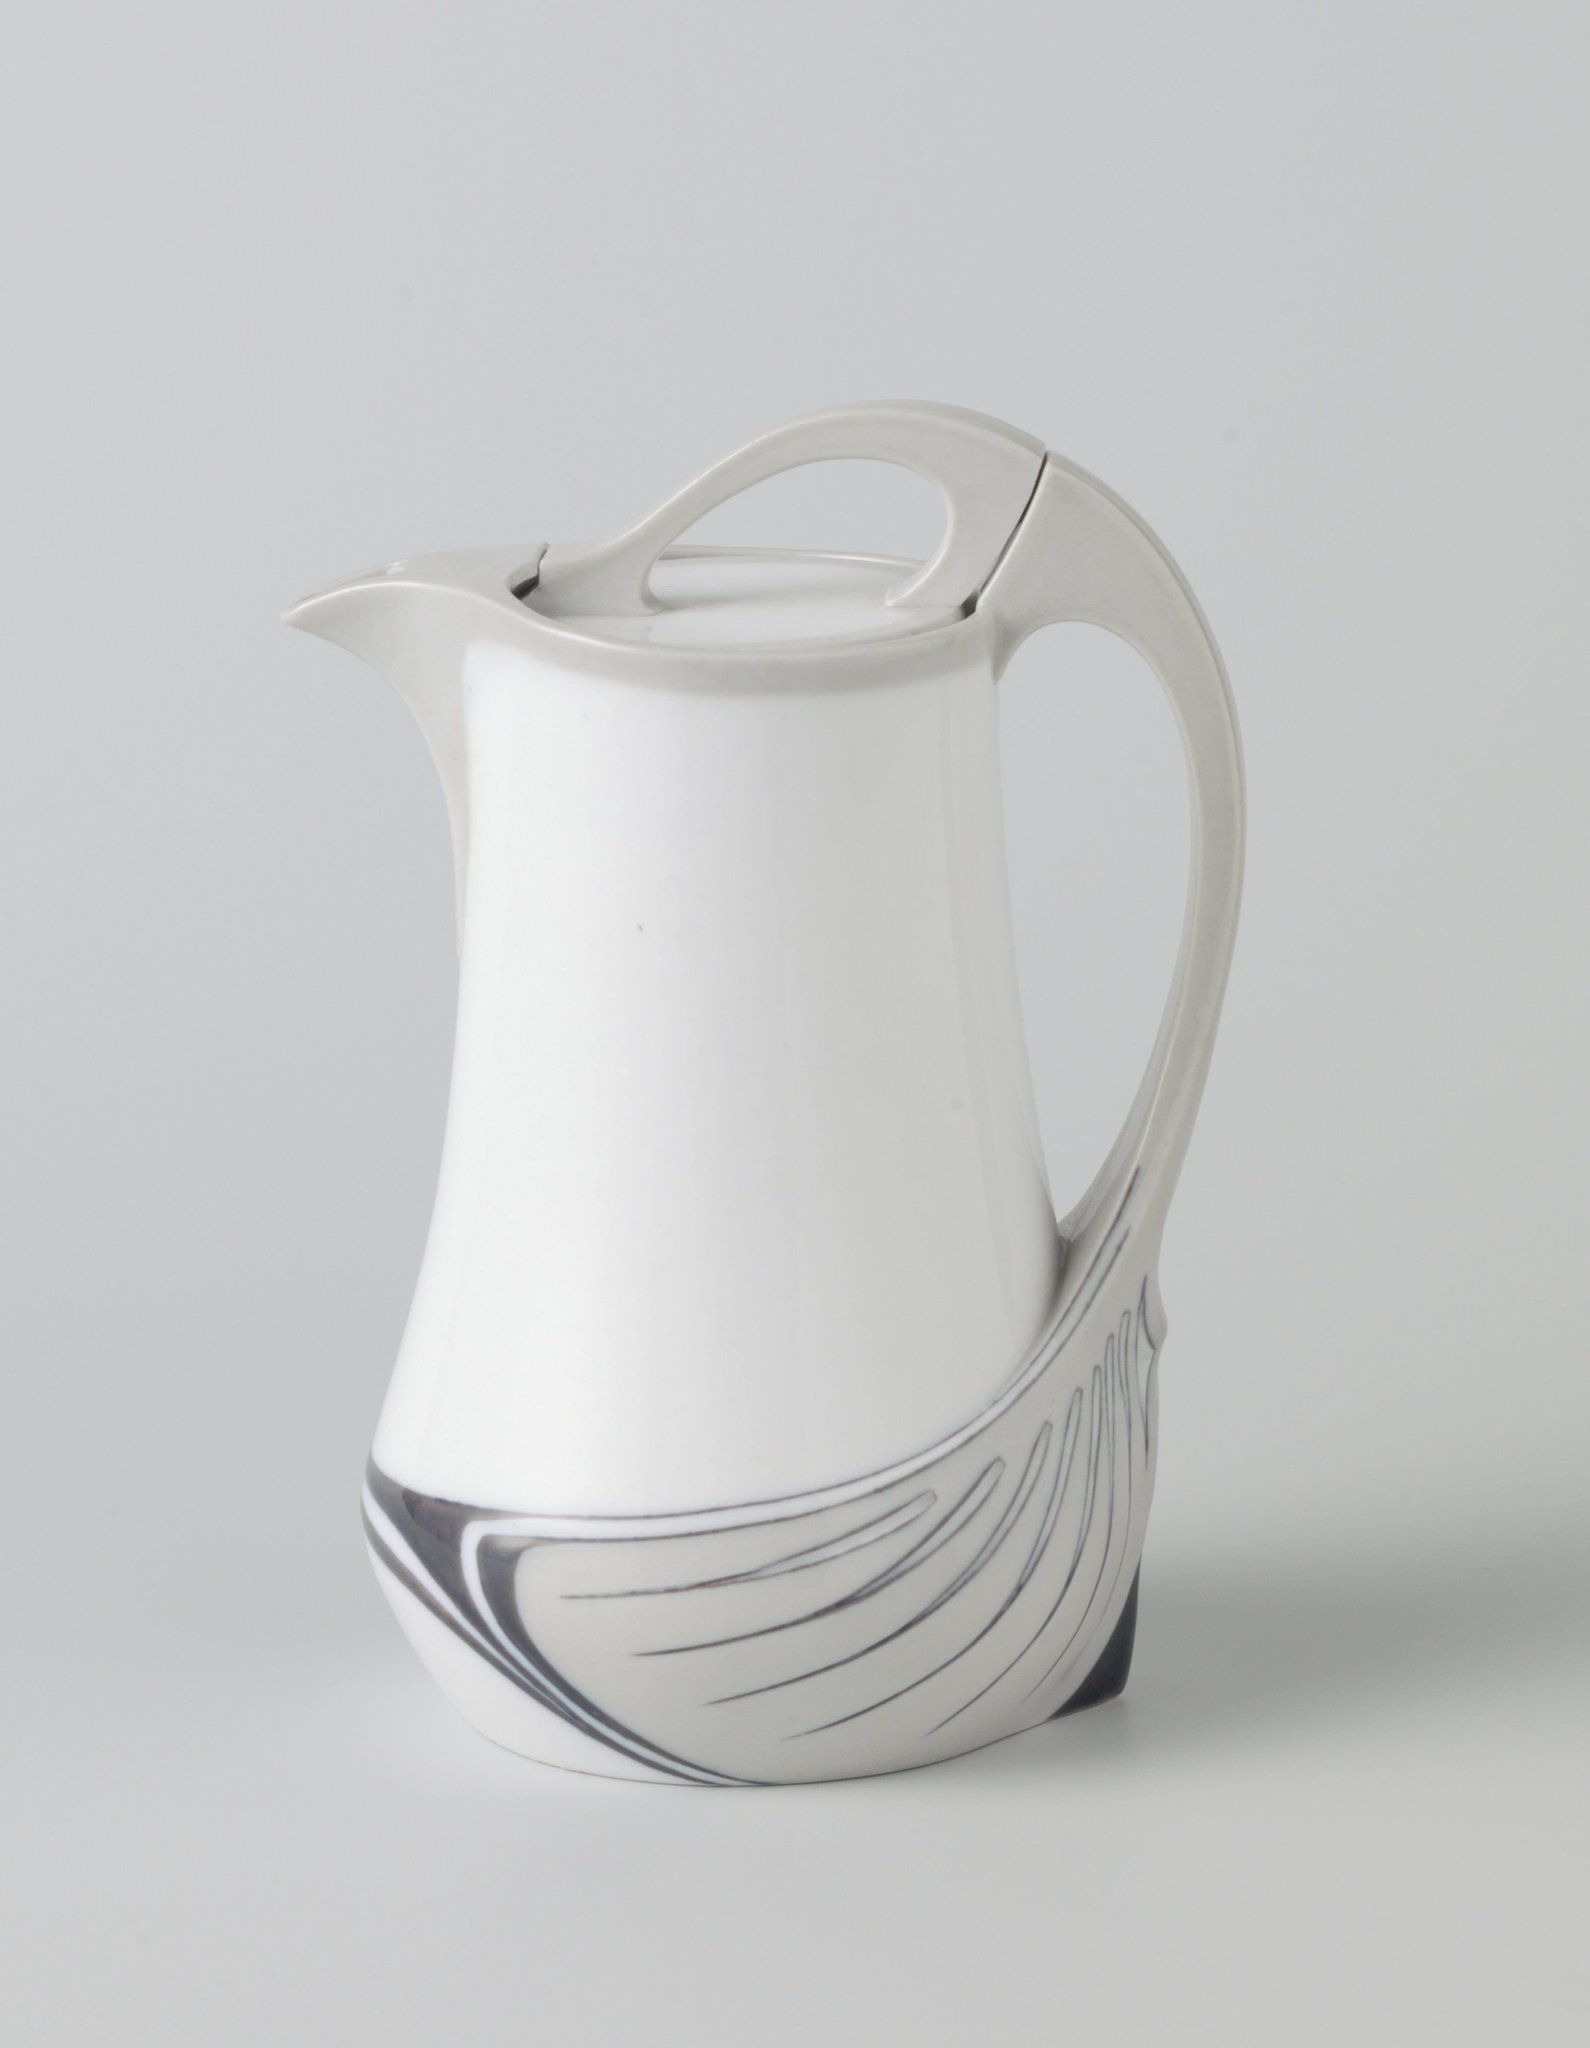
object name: eating drinking utensil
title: Deksel van mokkakan uit het koffie- en theeservies 'Saxonia'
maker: otto eduard voigt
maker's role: keramiekontwerper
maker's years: 1870-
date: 1904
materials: porcelain, chemical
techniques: painted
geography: meissen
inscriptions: factory mark, model number: ‘U 123’, mark: ‘V’, mark: ‘61’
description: Deksel van mokkakan van porselein, beschilderd in blauw en grijs.